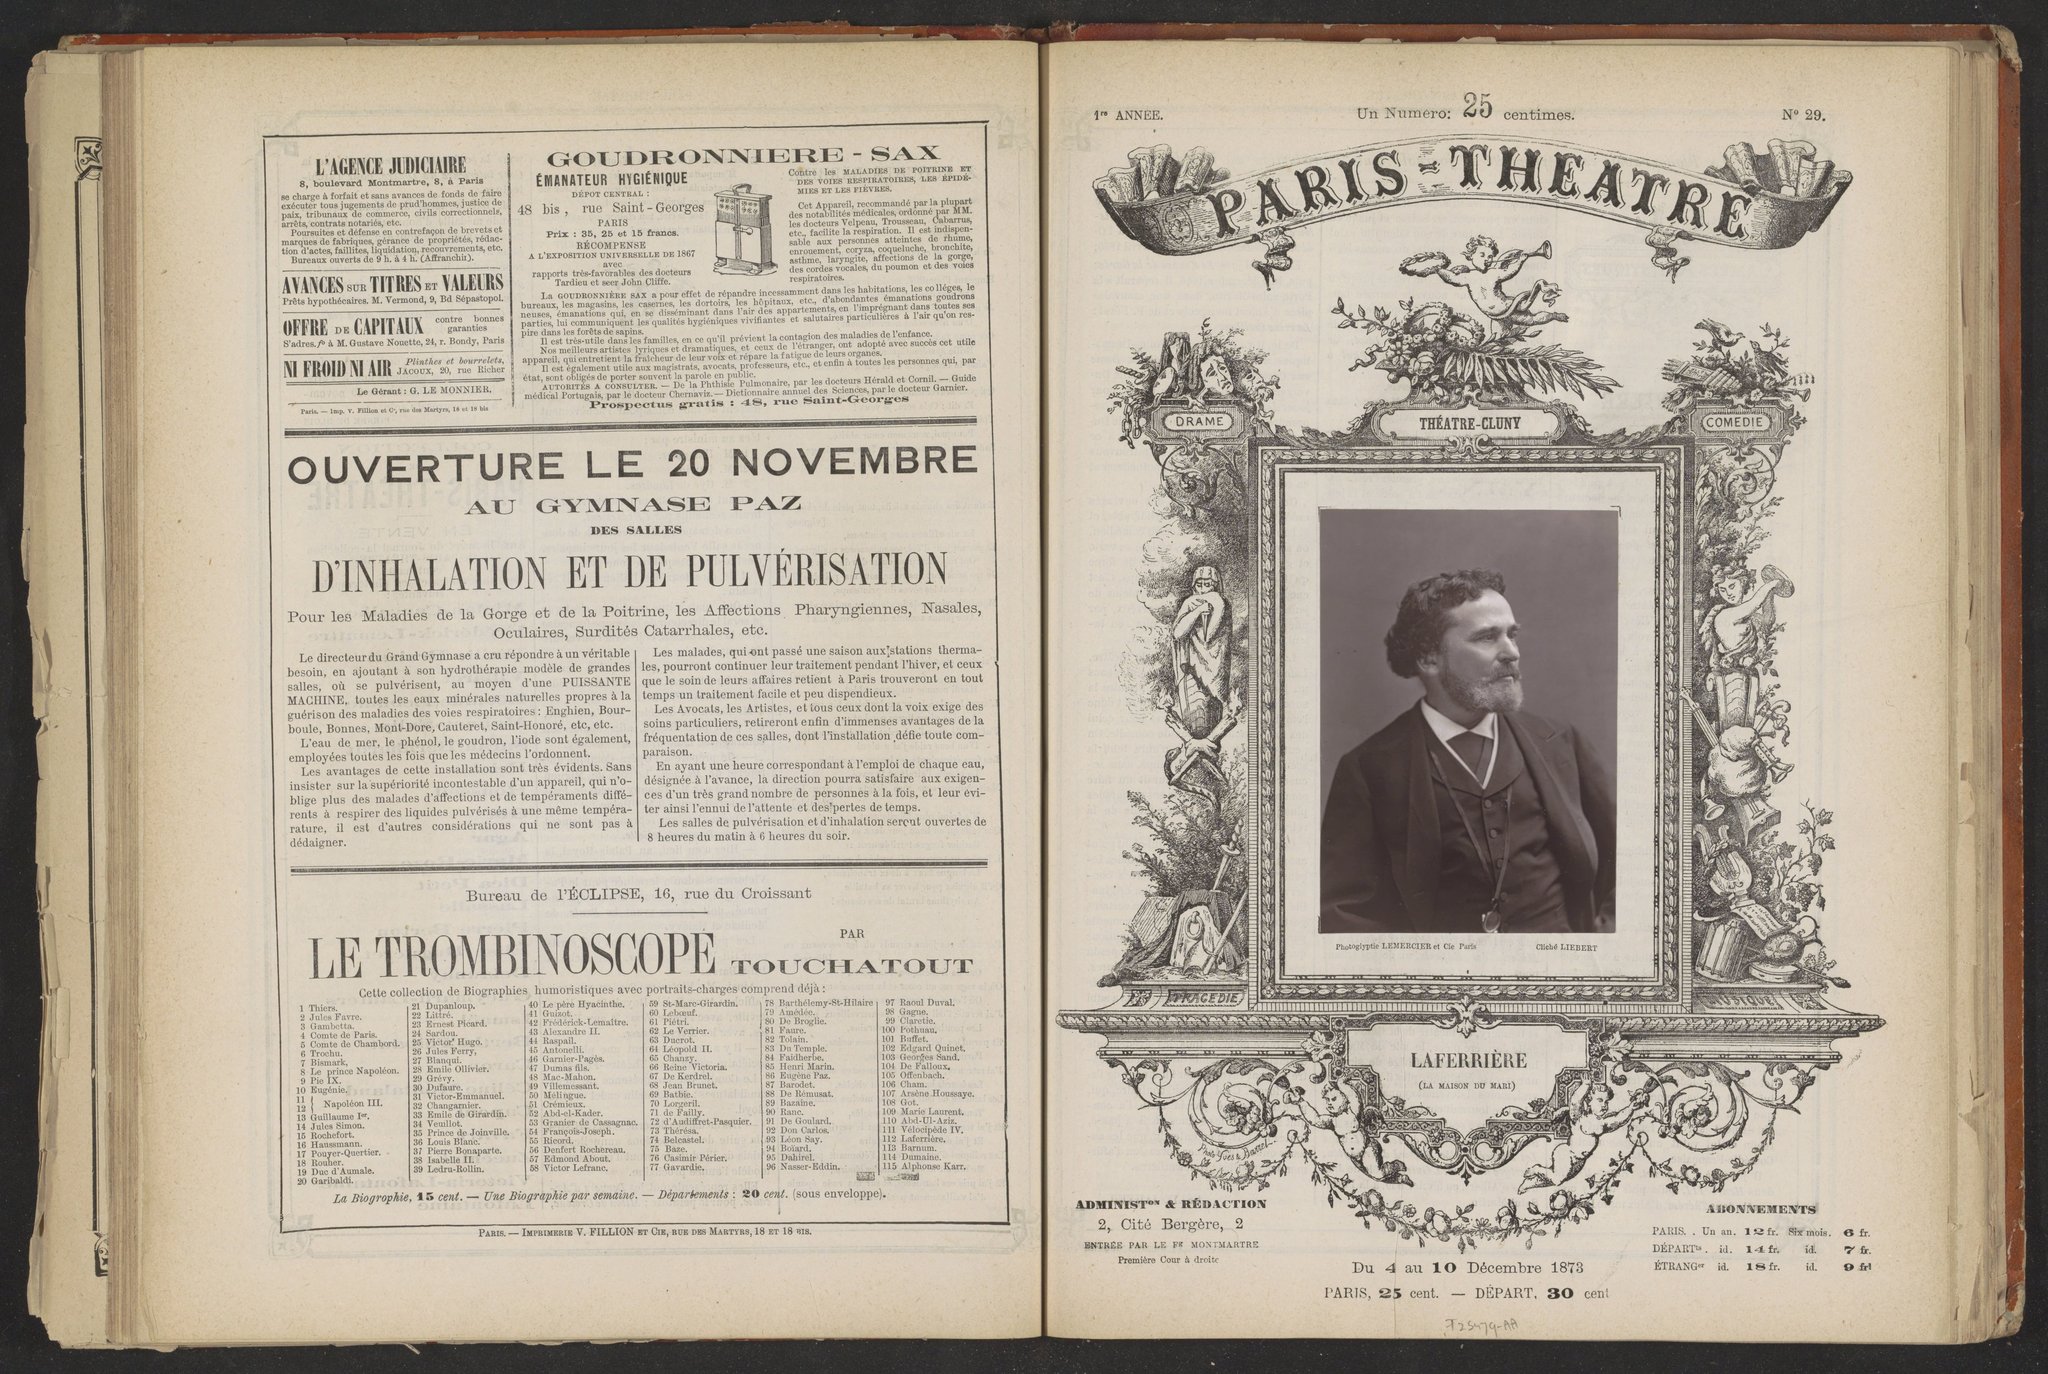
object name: photomechanical print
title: Laferrière (La maison du mari)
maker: alphonse-justin liébert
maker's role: fotograaf, marinier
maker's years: 1827-1914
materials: paper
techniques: woodburytype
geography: paris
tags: portrait of actor, actress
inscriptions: number: ‘No 29.’, inscription: ‘Du 4 au 10 Décembre 1873’